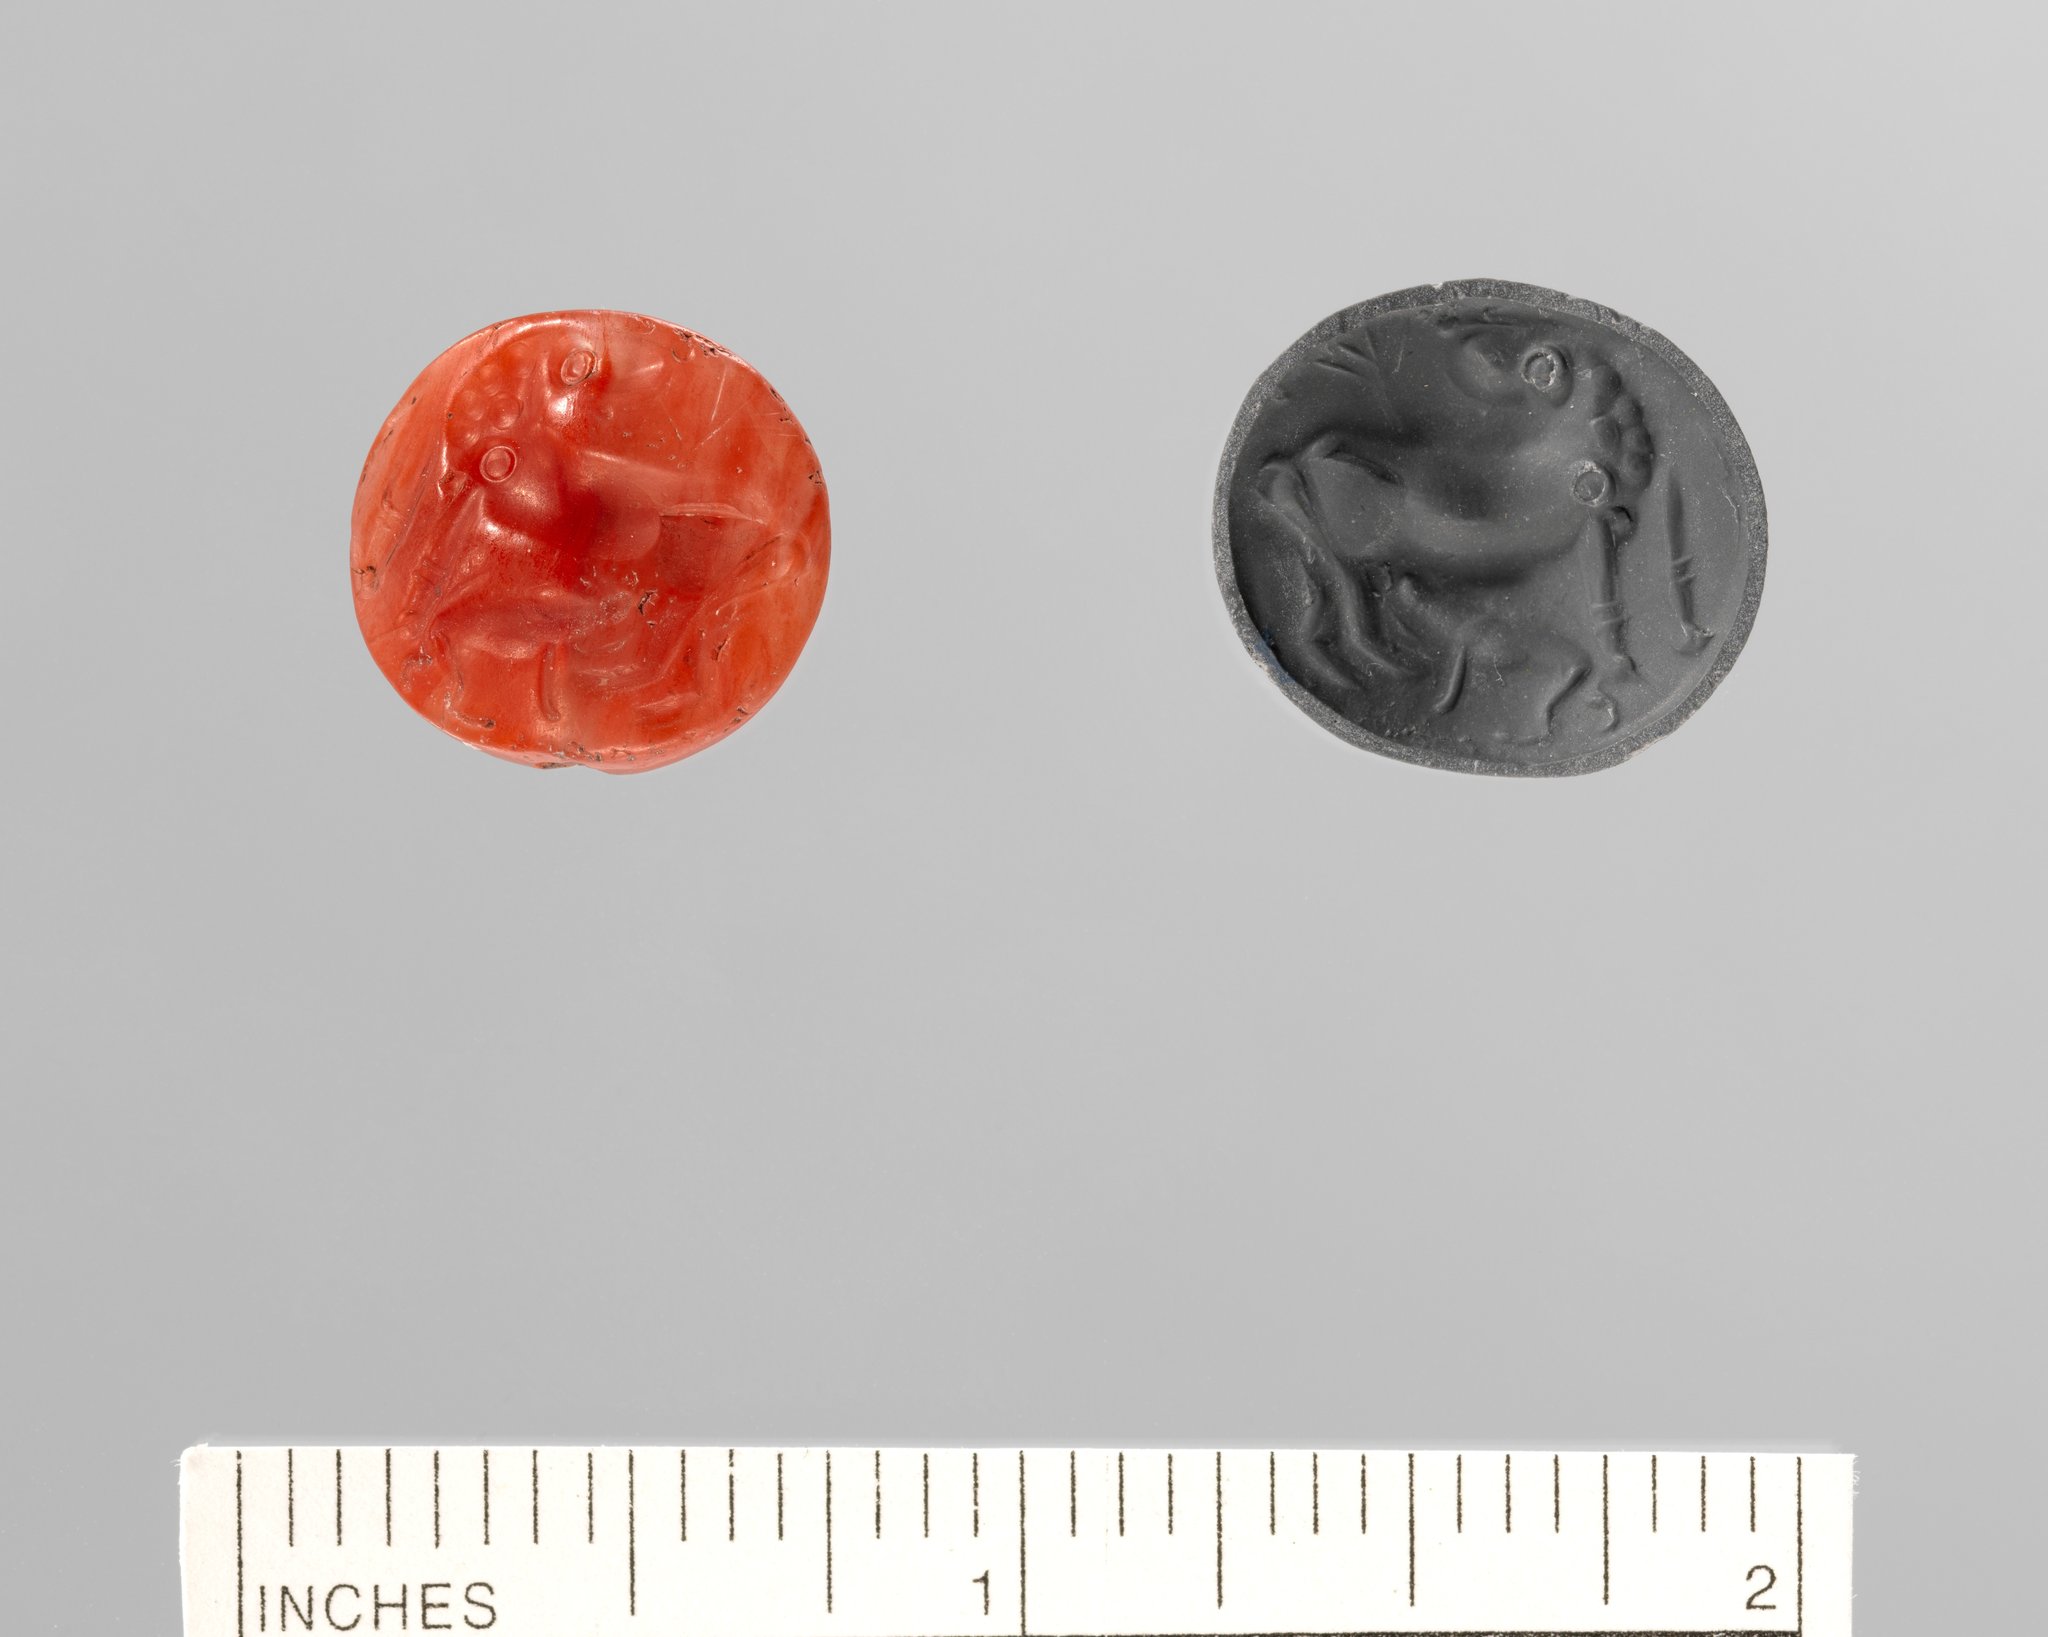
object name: seal, lentoid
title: Chalcedony Lentoid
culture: minoan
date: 1450-1375 BCE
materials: stone